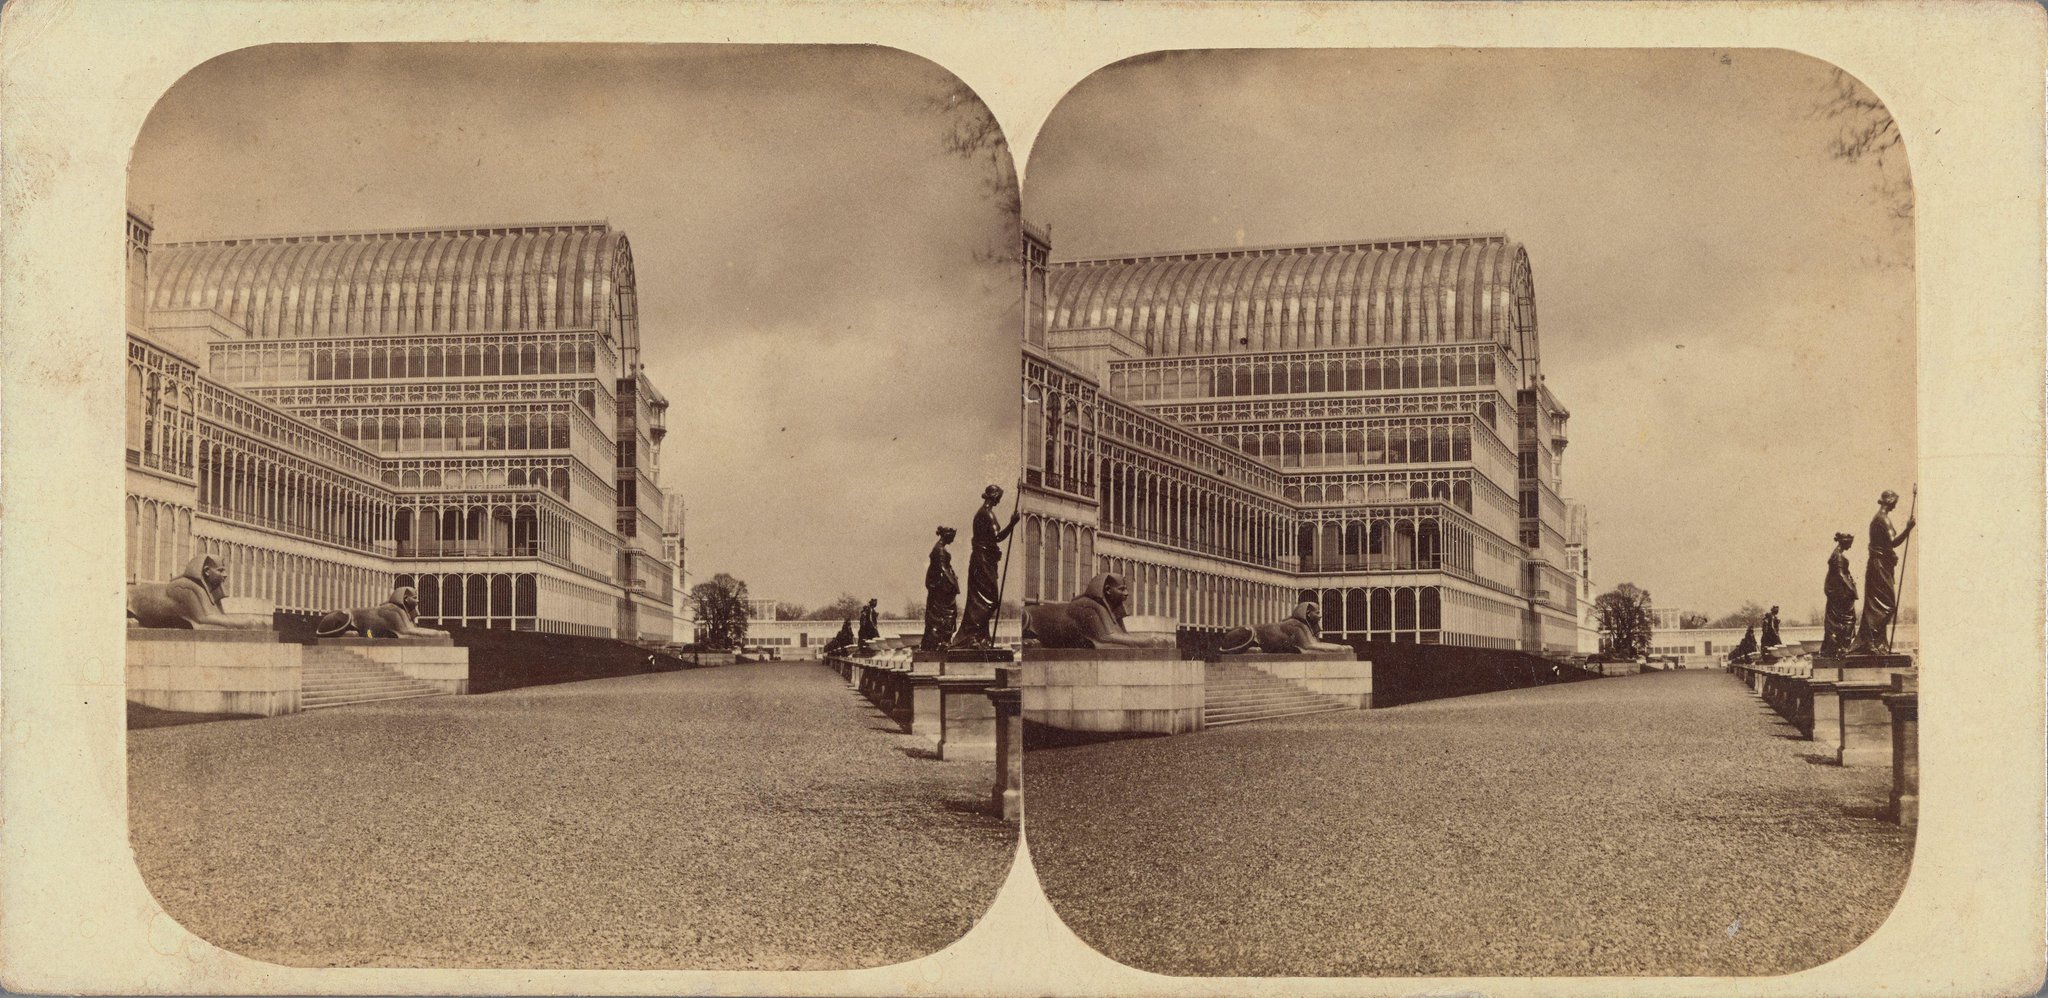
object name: stereograph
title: Crystal Palace. 22. Exterior of the Palace, from the Grand Terraces.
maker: Anonymous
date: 1870-1890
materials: cardboard, paper, photographic support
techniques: albumen print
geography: crystal palace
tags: exterior ~ representation of a building